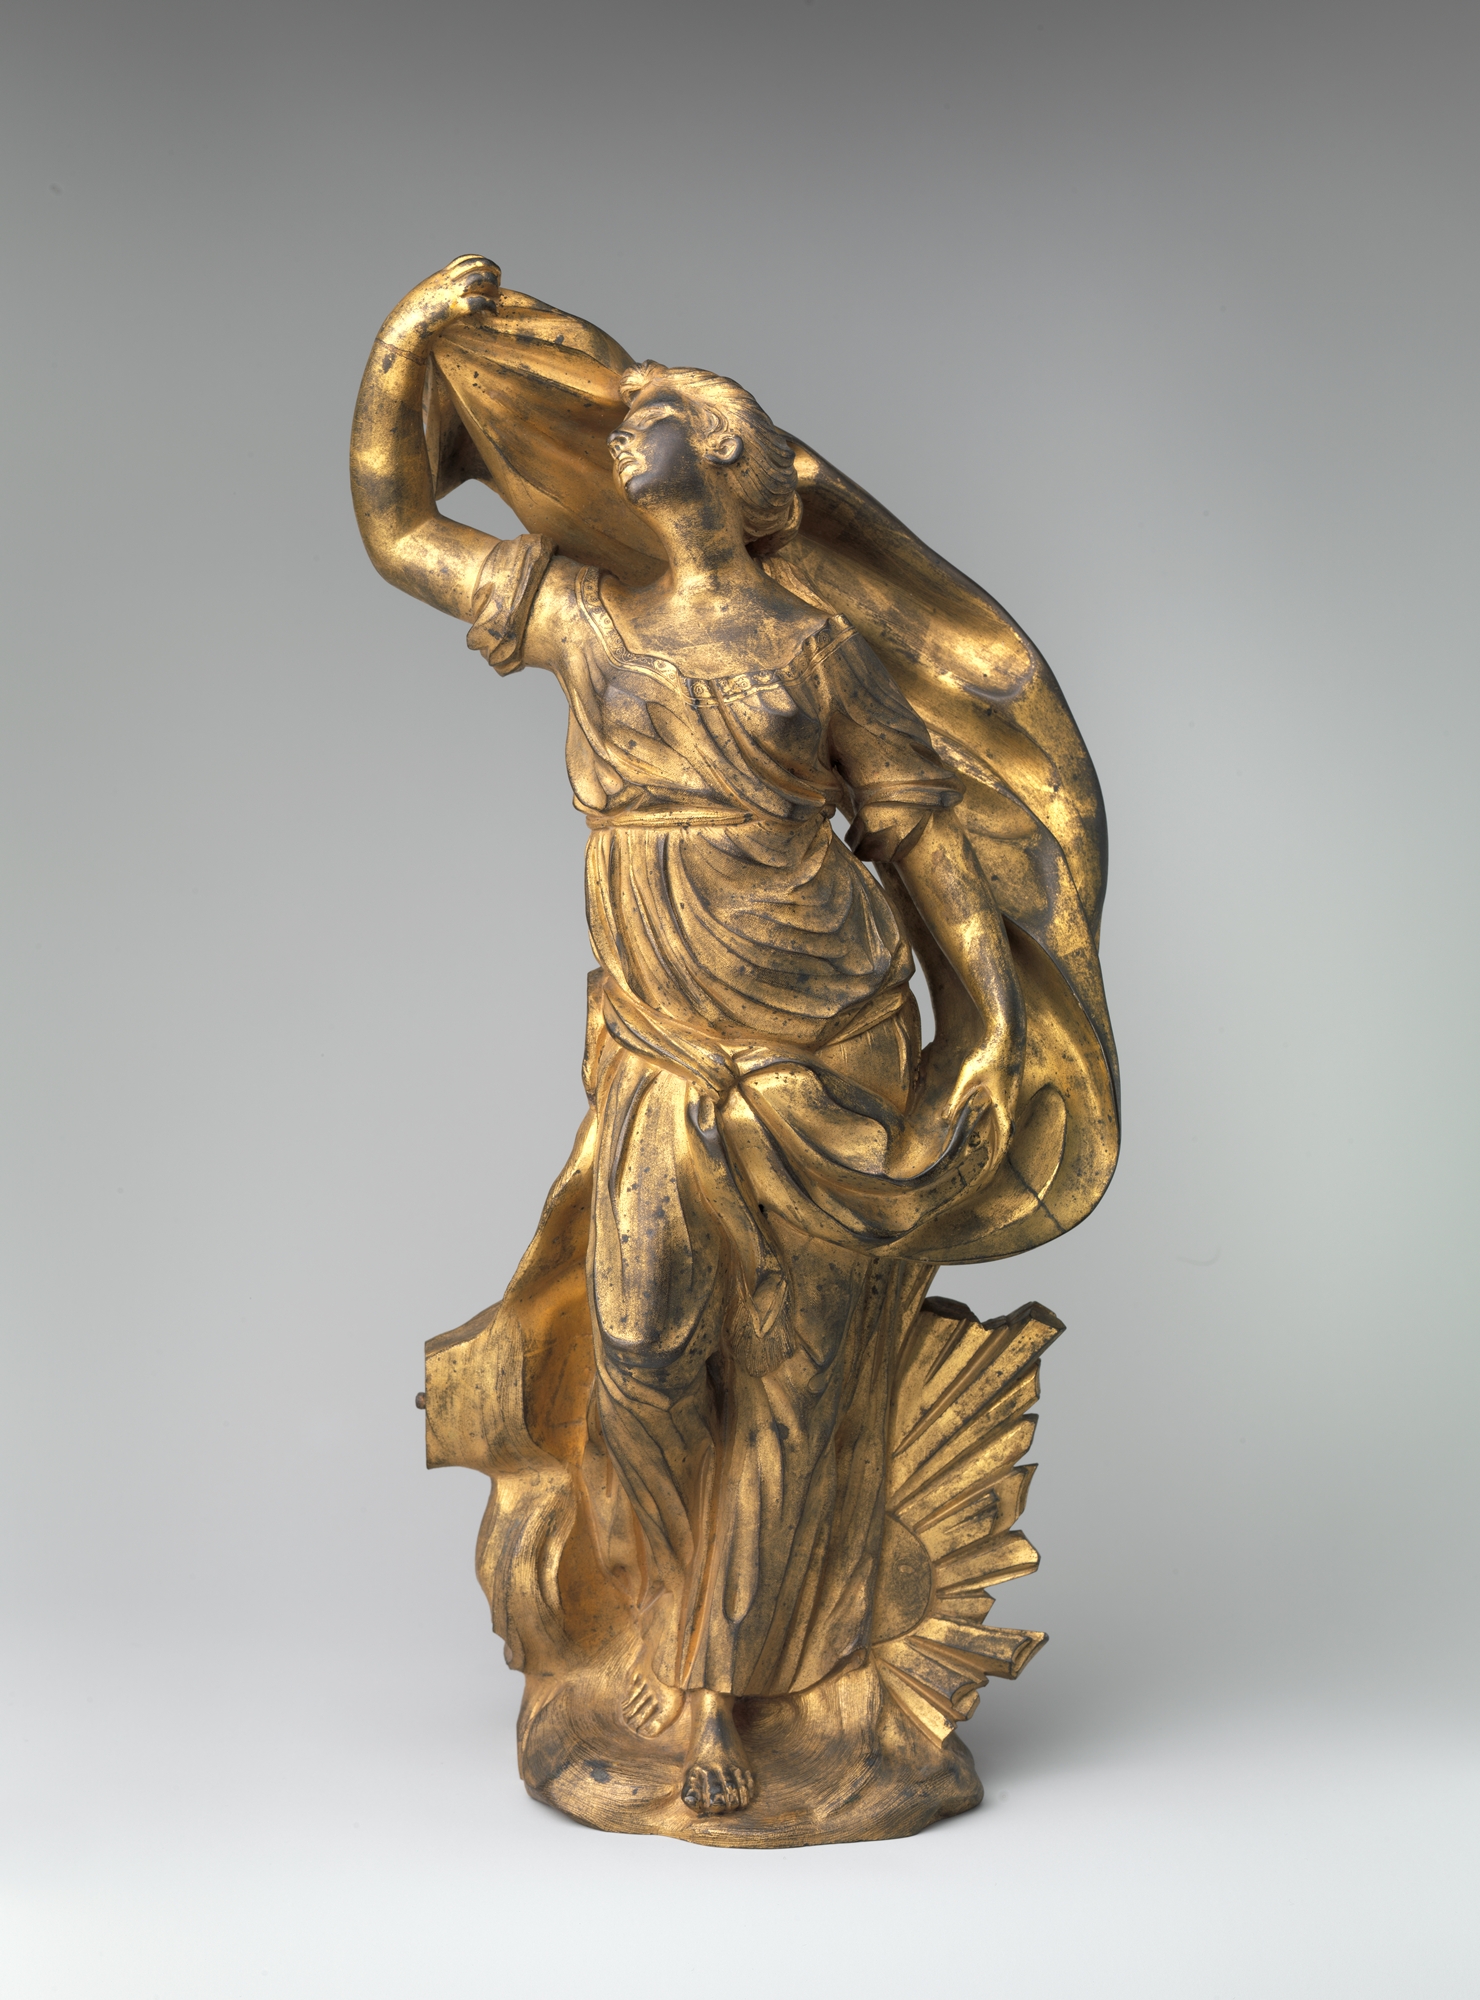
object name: statuette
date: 1734-1766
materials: gilt bronze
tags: women